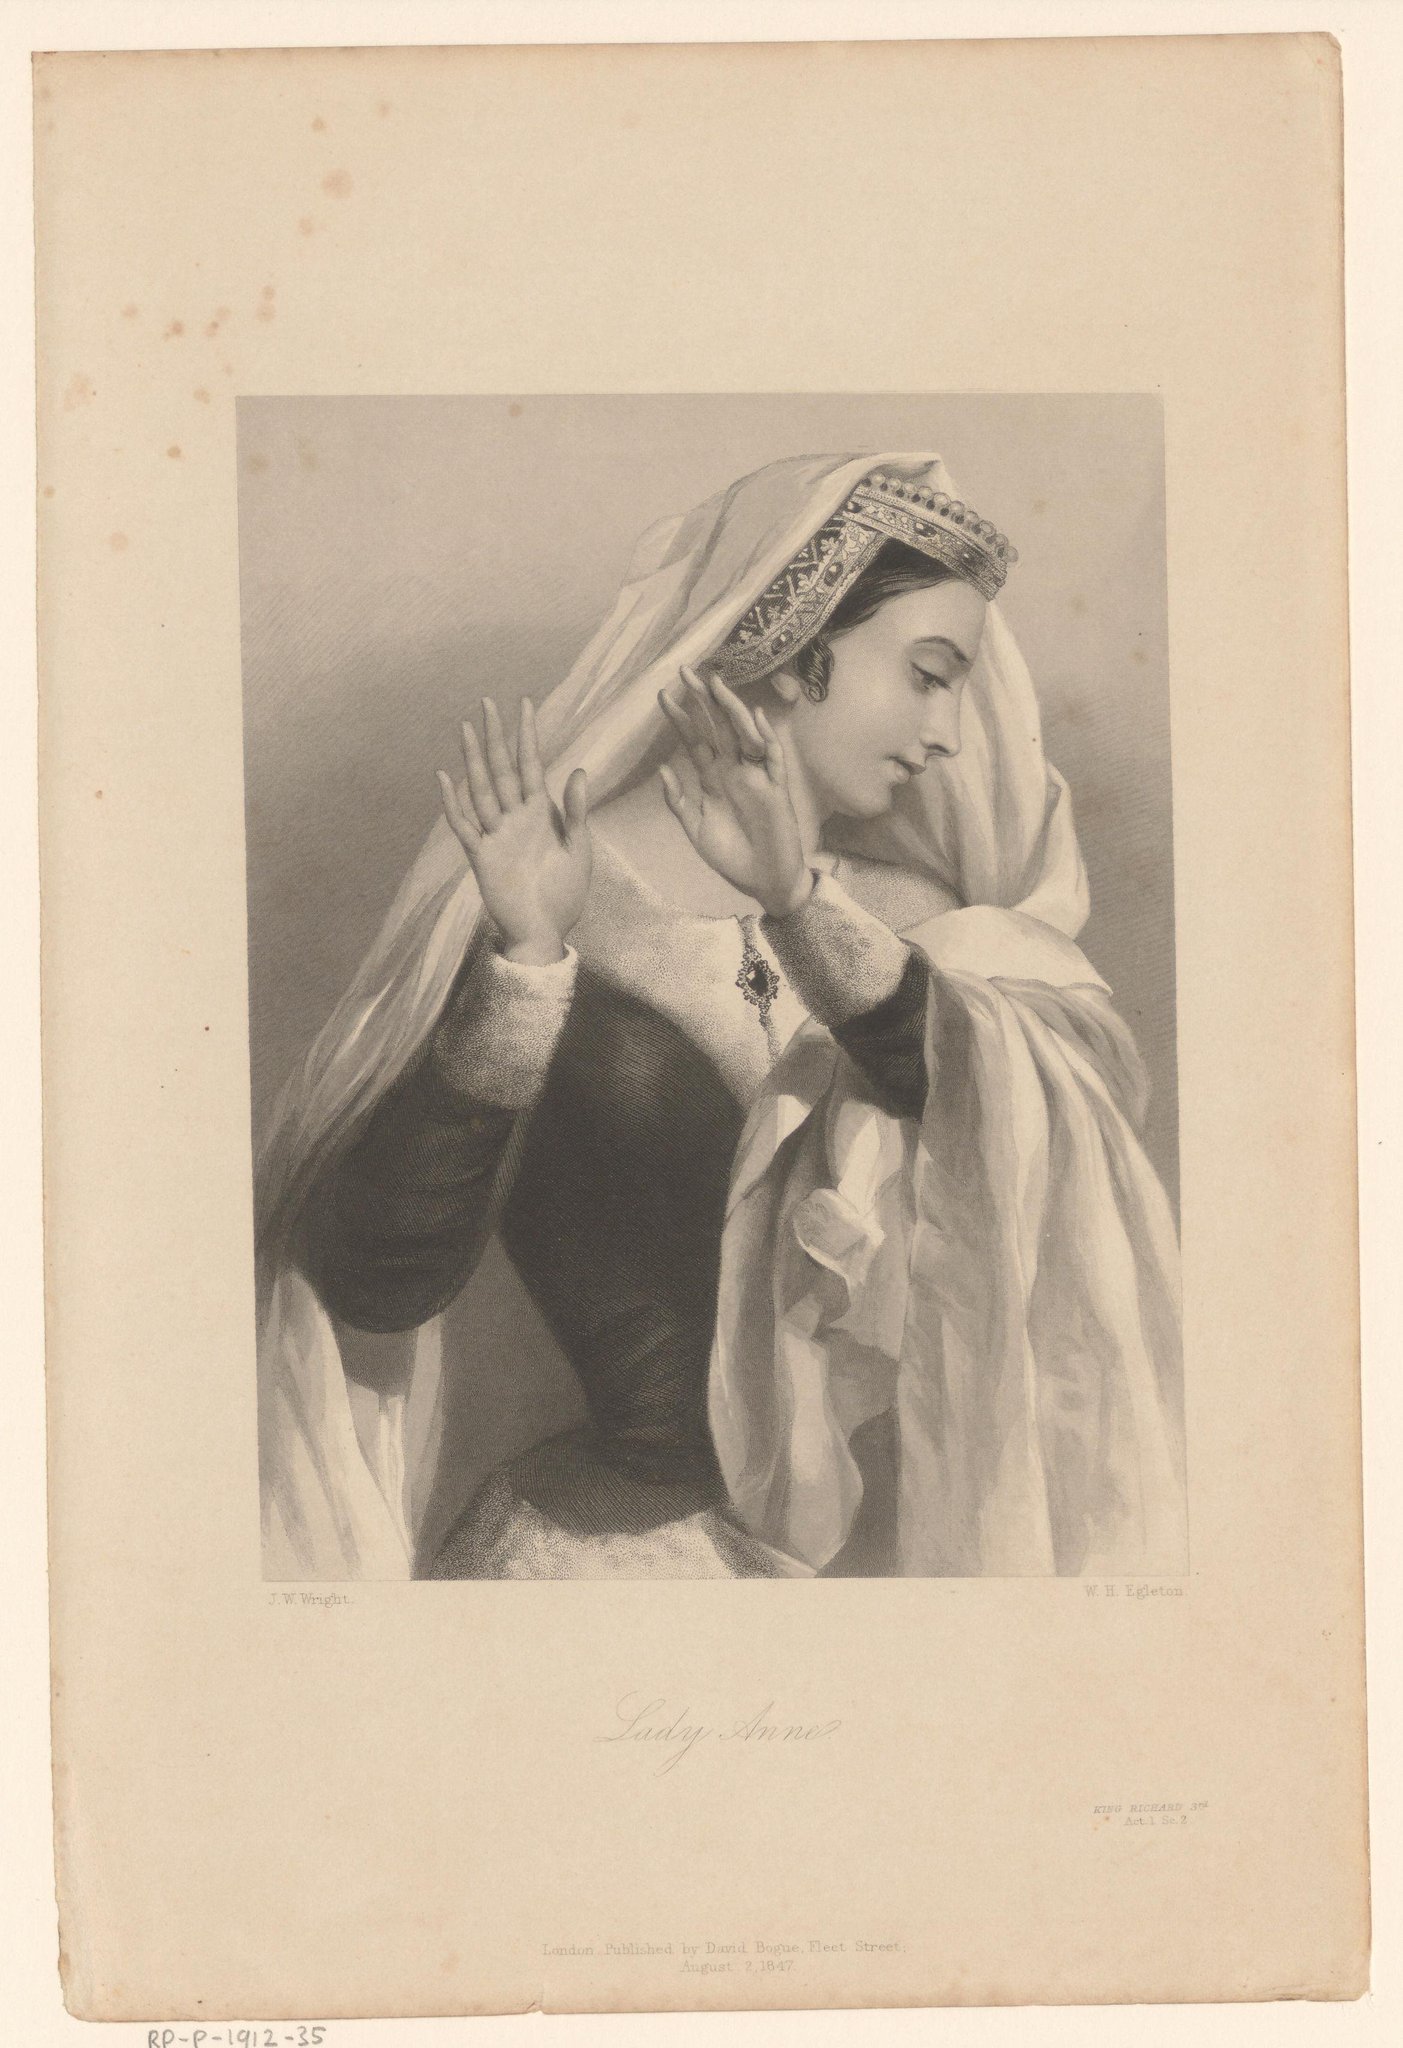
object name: book illustration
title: Lady Anne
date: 1808-1847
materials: paper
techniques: etching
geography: london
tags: william shakespeare, arm raised, with fingers spread out - aa - both arms or hands, female literary characters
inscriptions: collector's mark: Lugt 2228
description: Prent ook gebruikt in: Heath, Charles. The heroines of Shakespeare: comprising the principal female characters in the plays of the great poet. Londen: David Bogue, 1848.